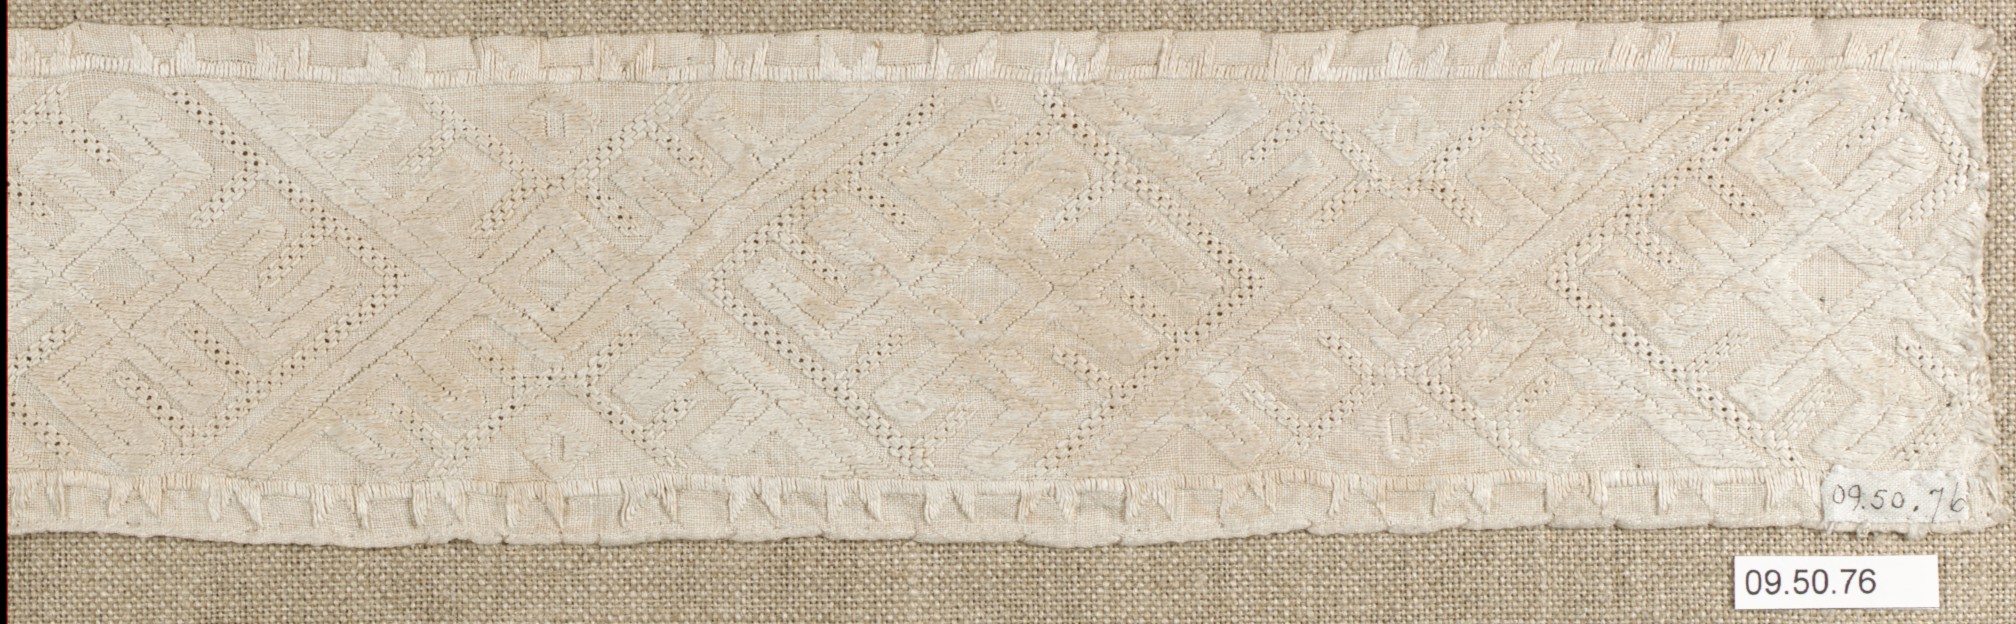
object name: strip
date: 1601-1700